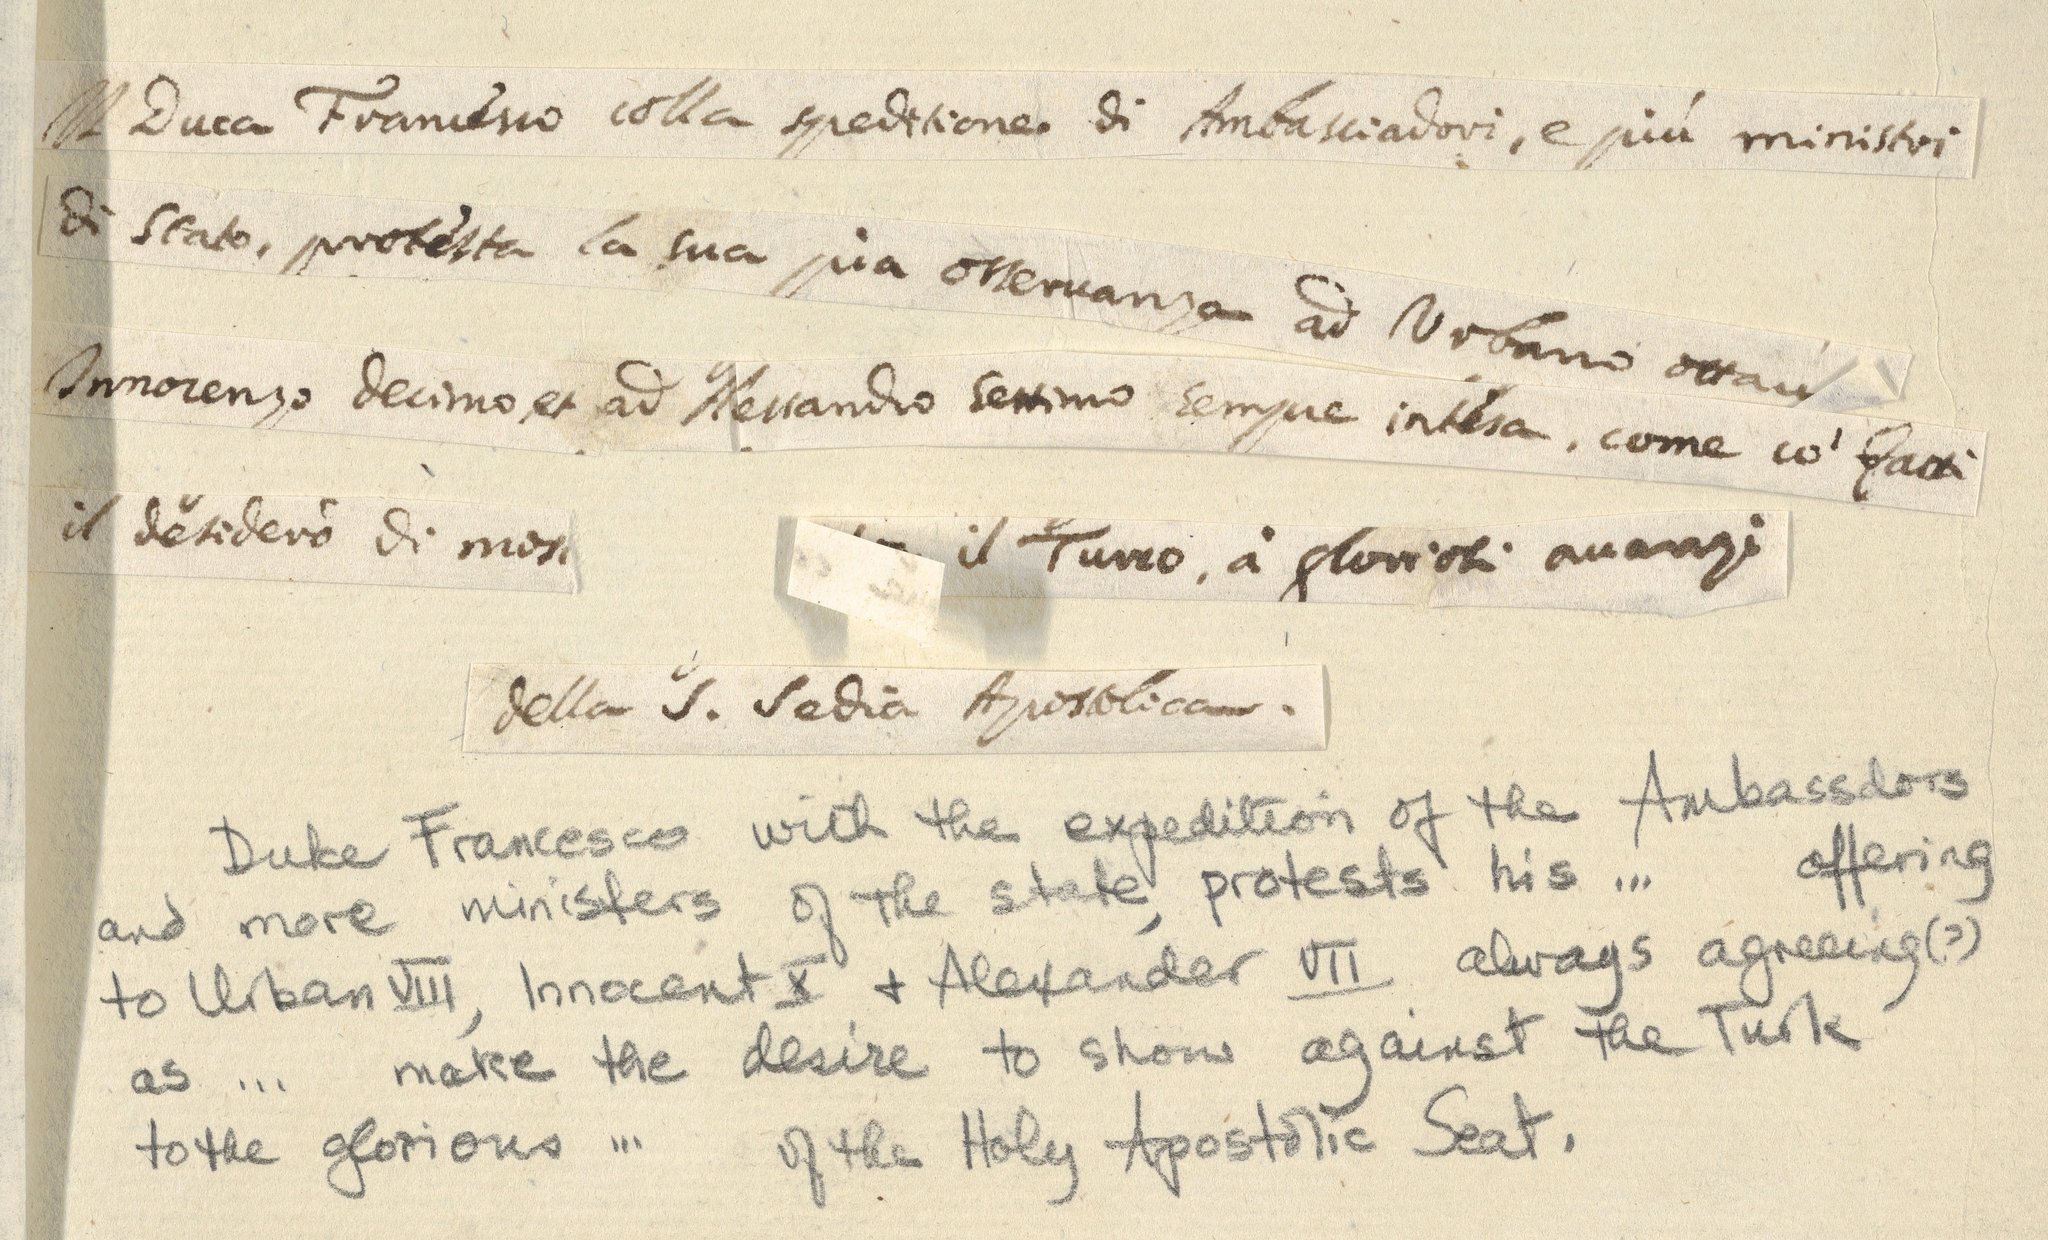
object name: print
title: Francesco I d'Este, with the Expedition of the Embassadors and Ministers of State, Declares his Ofference to Urban VIII, Innocent X, and Alexander VII to Continue to Defend Against the Turks, from "L'Idea di un Principe ed Eroe Cristiano in Francesco I d'Este, di Modena e Reggio Duca VIII [...]"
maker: bartolomeo fenice (fénis)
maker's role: artist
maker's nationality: italian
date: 1659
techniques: etching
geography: italy